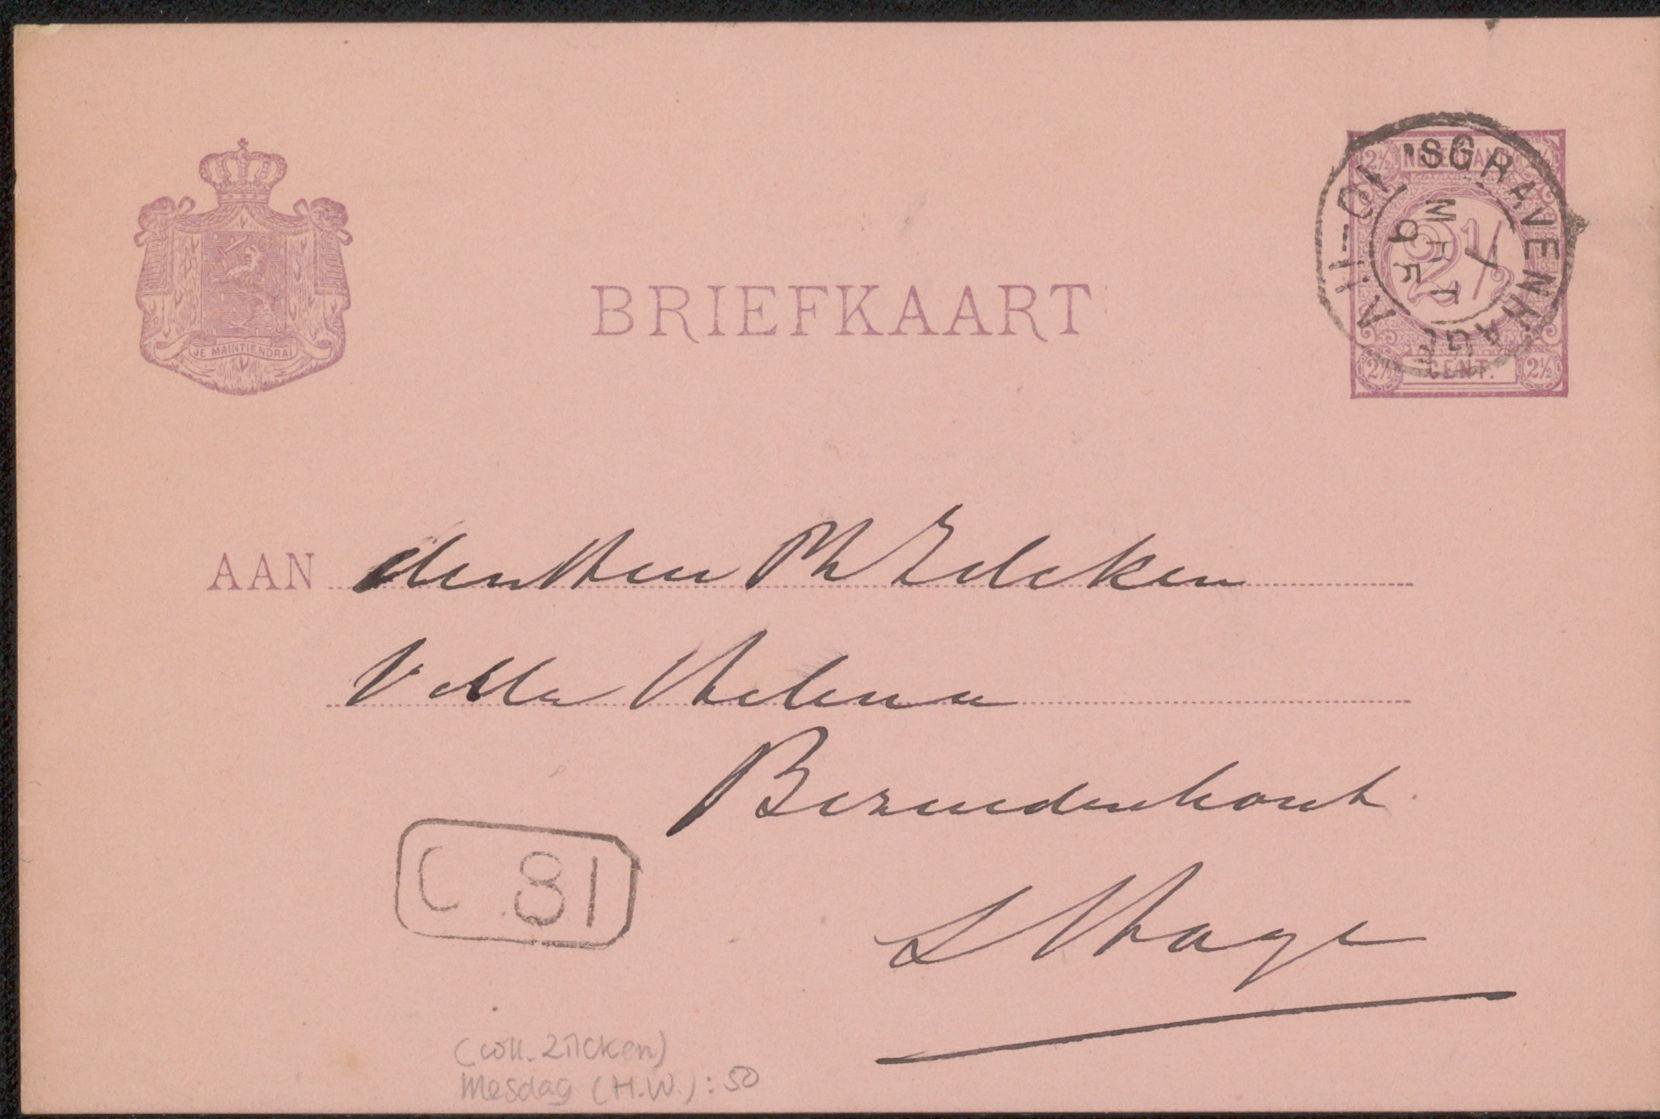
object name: postcard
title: Briefkaart aan Philip Zilcken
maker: hendrik willem mesdag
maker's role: draughtsman, painter, print maker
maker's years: 1831-1915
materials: cardboard, ink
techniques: pen, writing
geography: the hague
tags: philip zilcken, the graphic arts, painting (including book-illumination, miniature-painting), venice